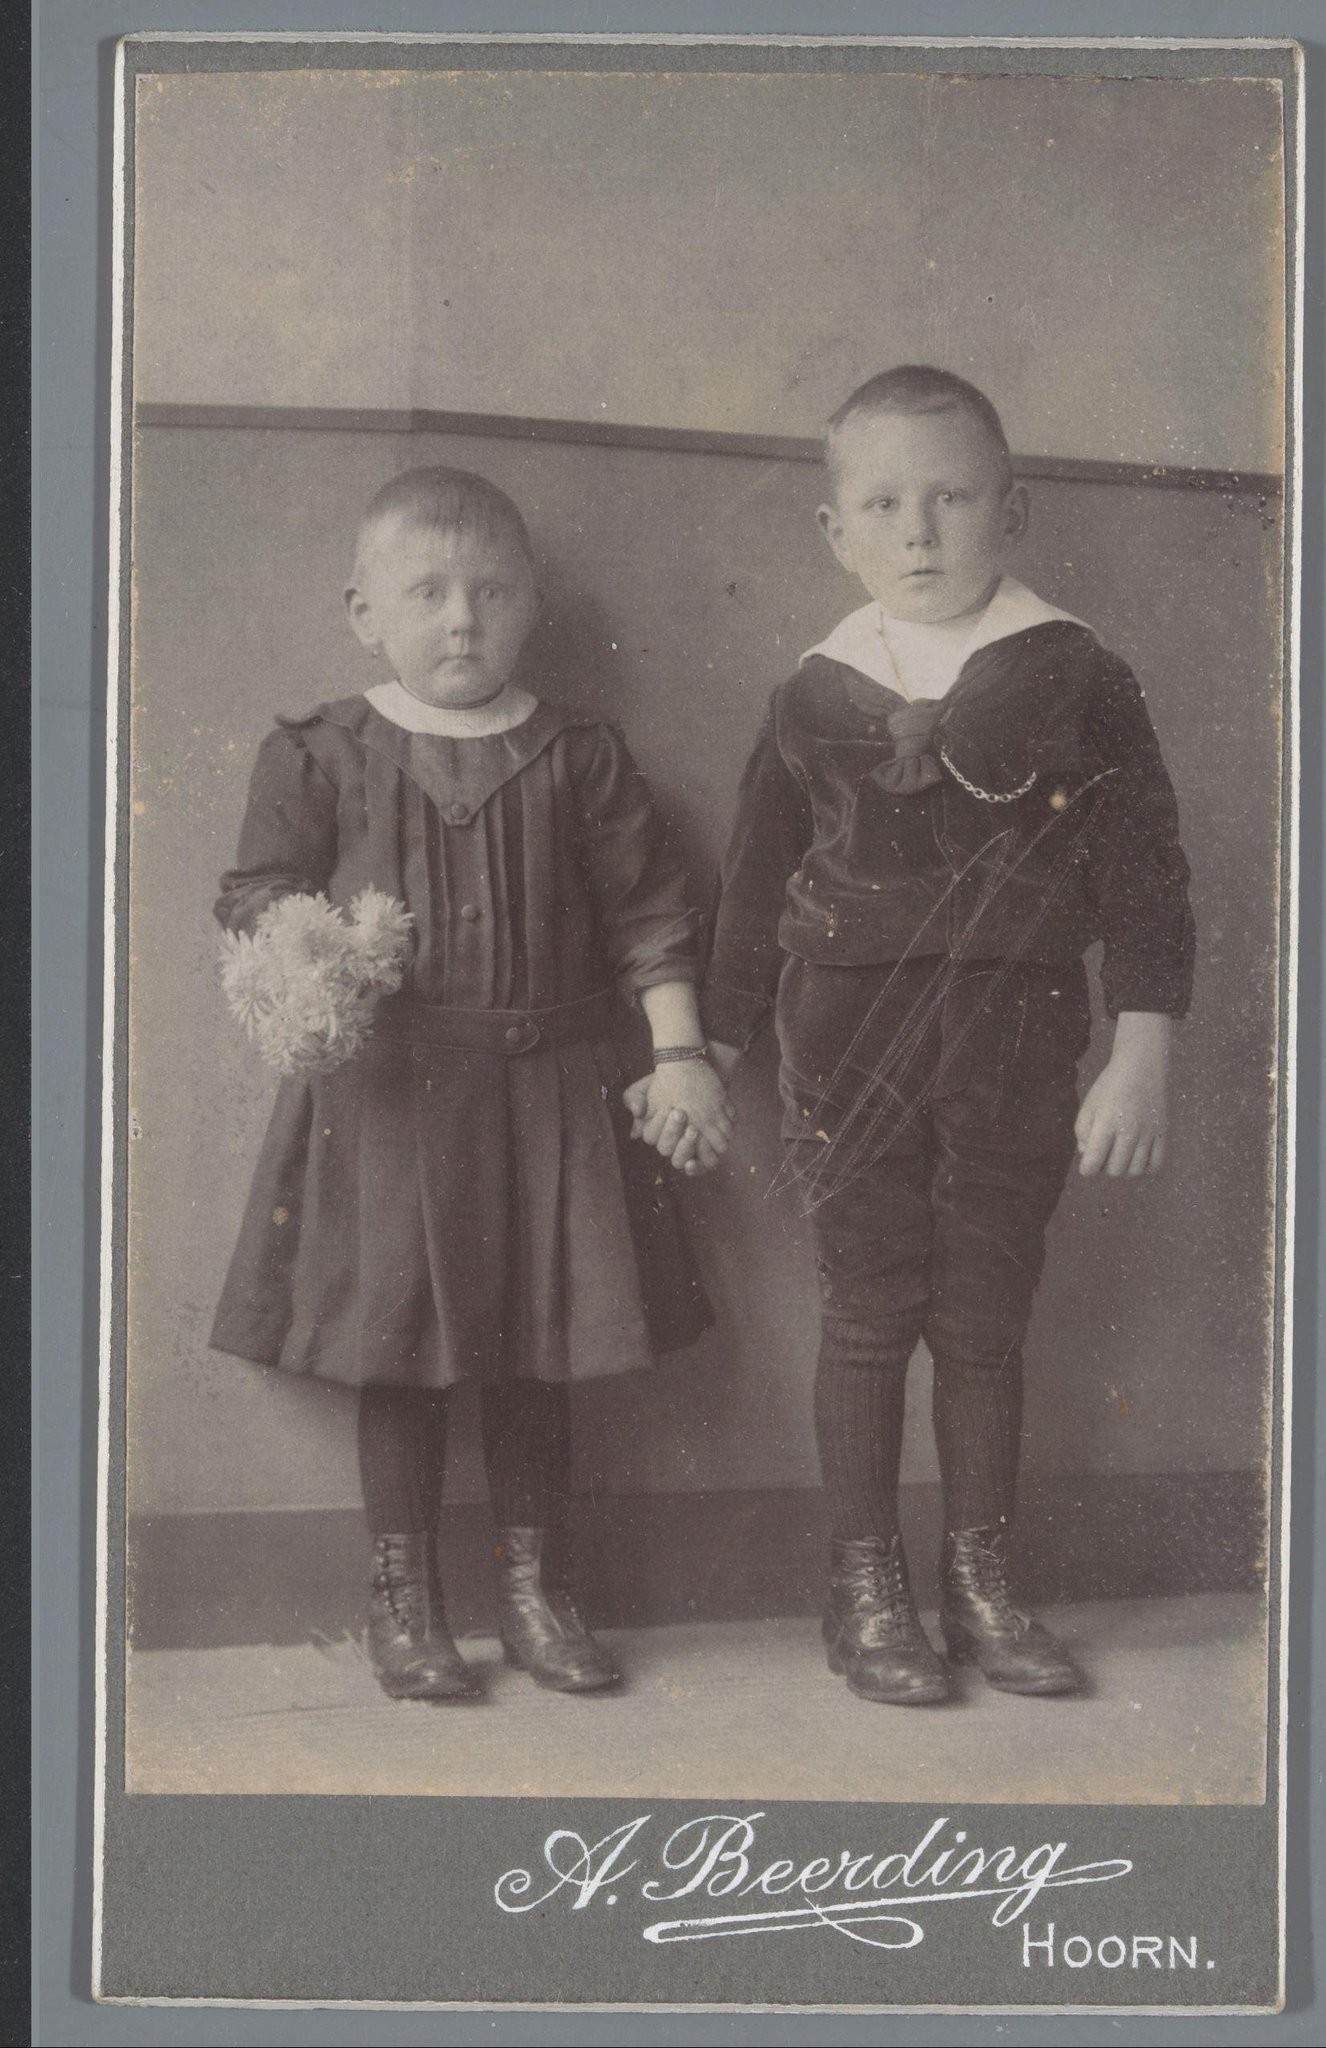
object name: carte de visite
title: Portret van Pieter en Eegje Haan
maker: alida beerding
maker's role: fotograaf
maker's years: 1875-1949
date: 1912-1928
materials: paper, cardboard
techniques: collodion silver print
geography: hoorn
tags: toddler, historical persons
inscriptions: inscription: ‘Pieter Haan/ Eegje Haan’